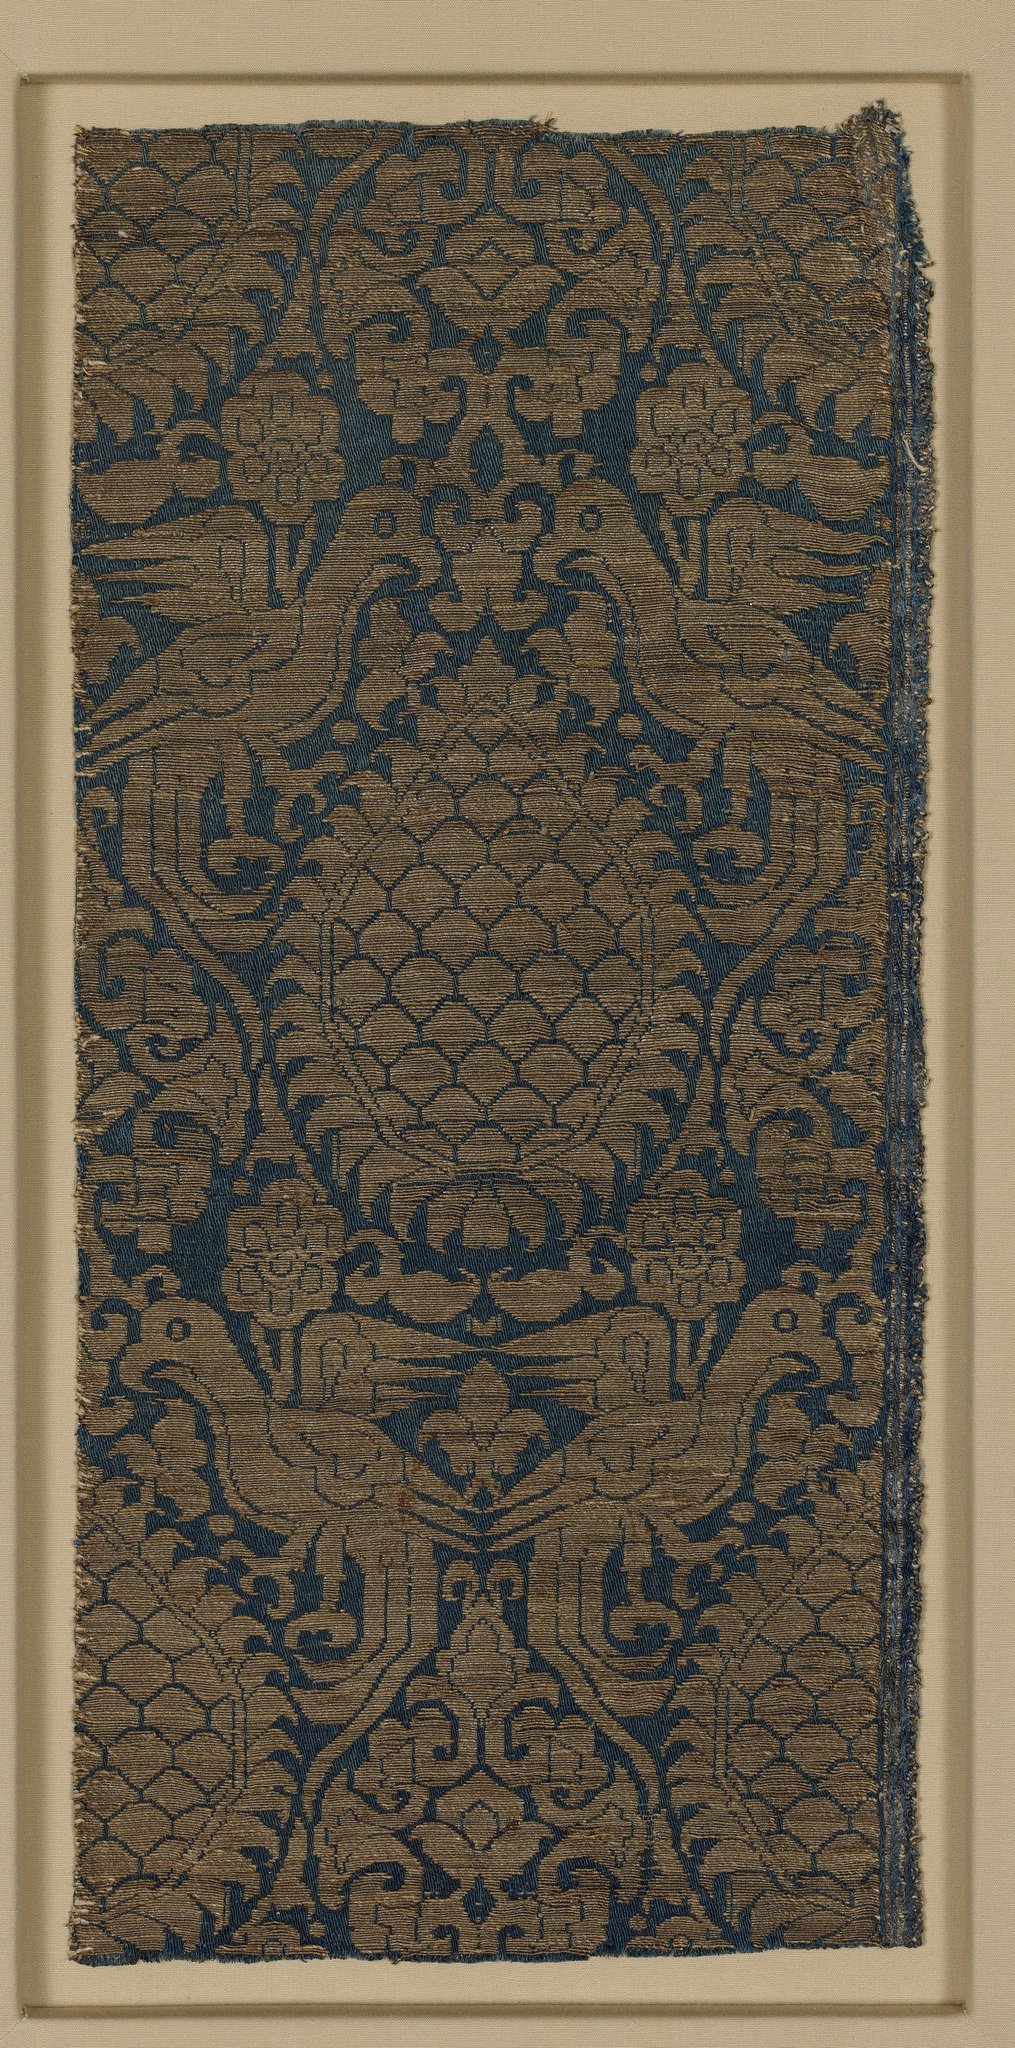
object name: fragment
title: Textile Fragment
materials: animal substrate, cotton, silk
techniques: lampas, silvered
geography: islamic lands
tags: birds